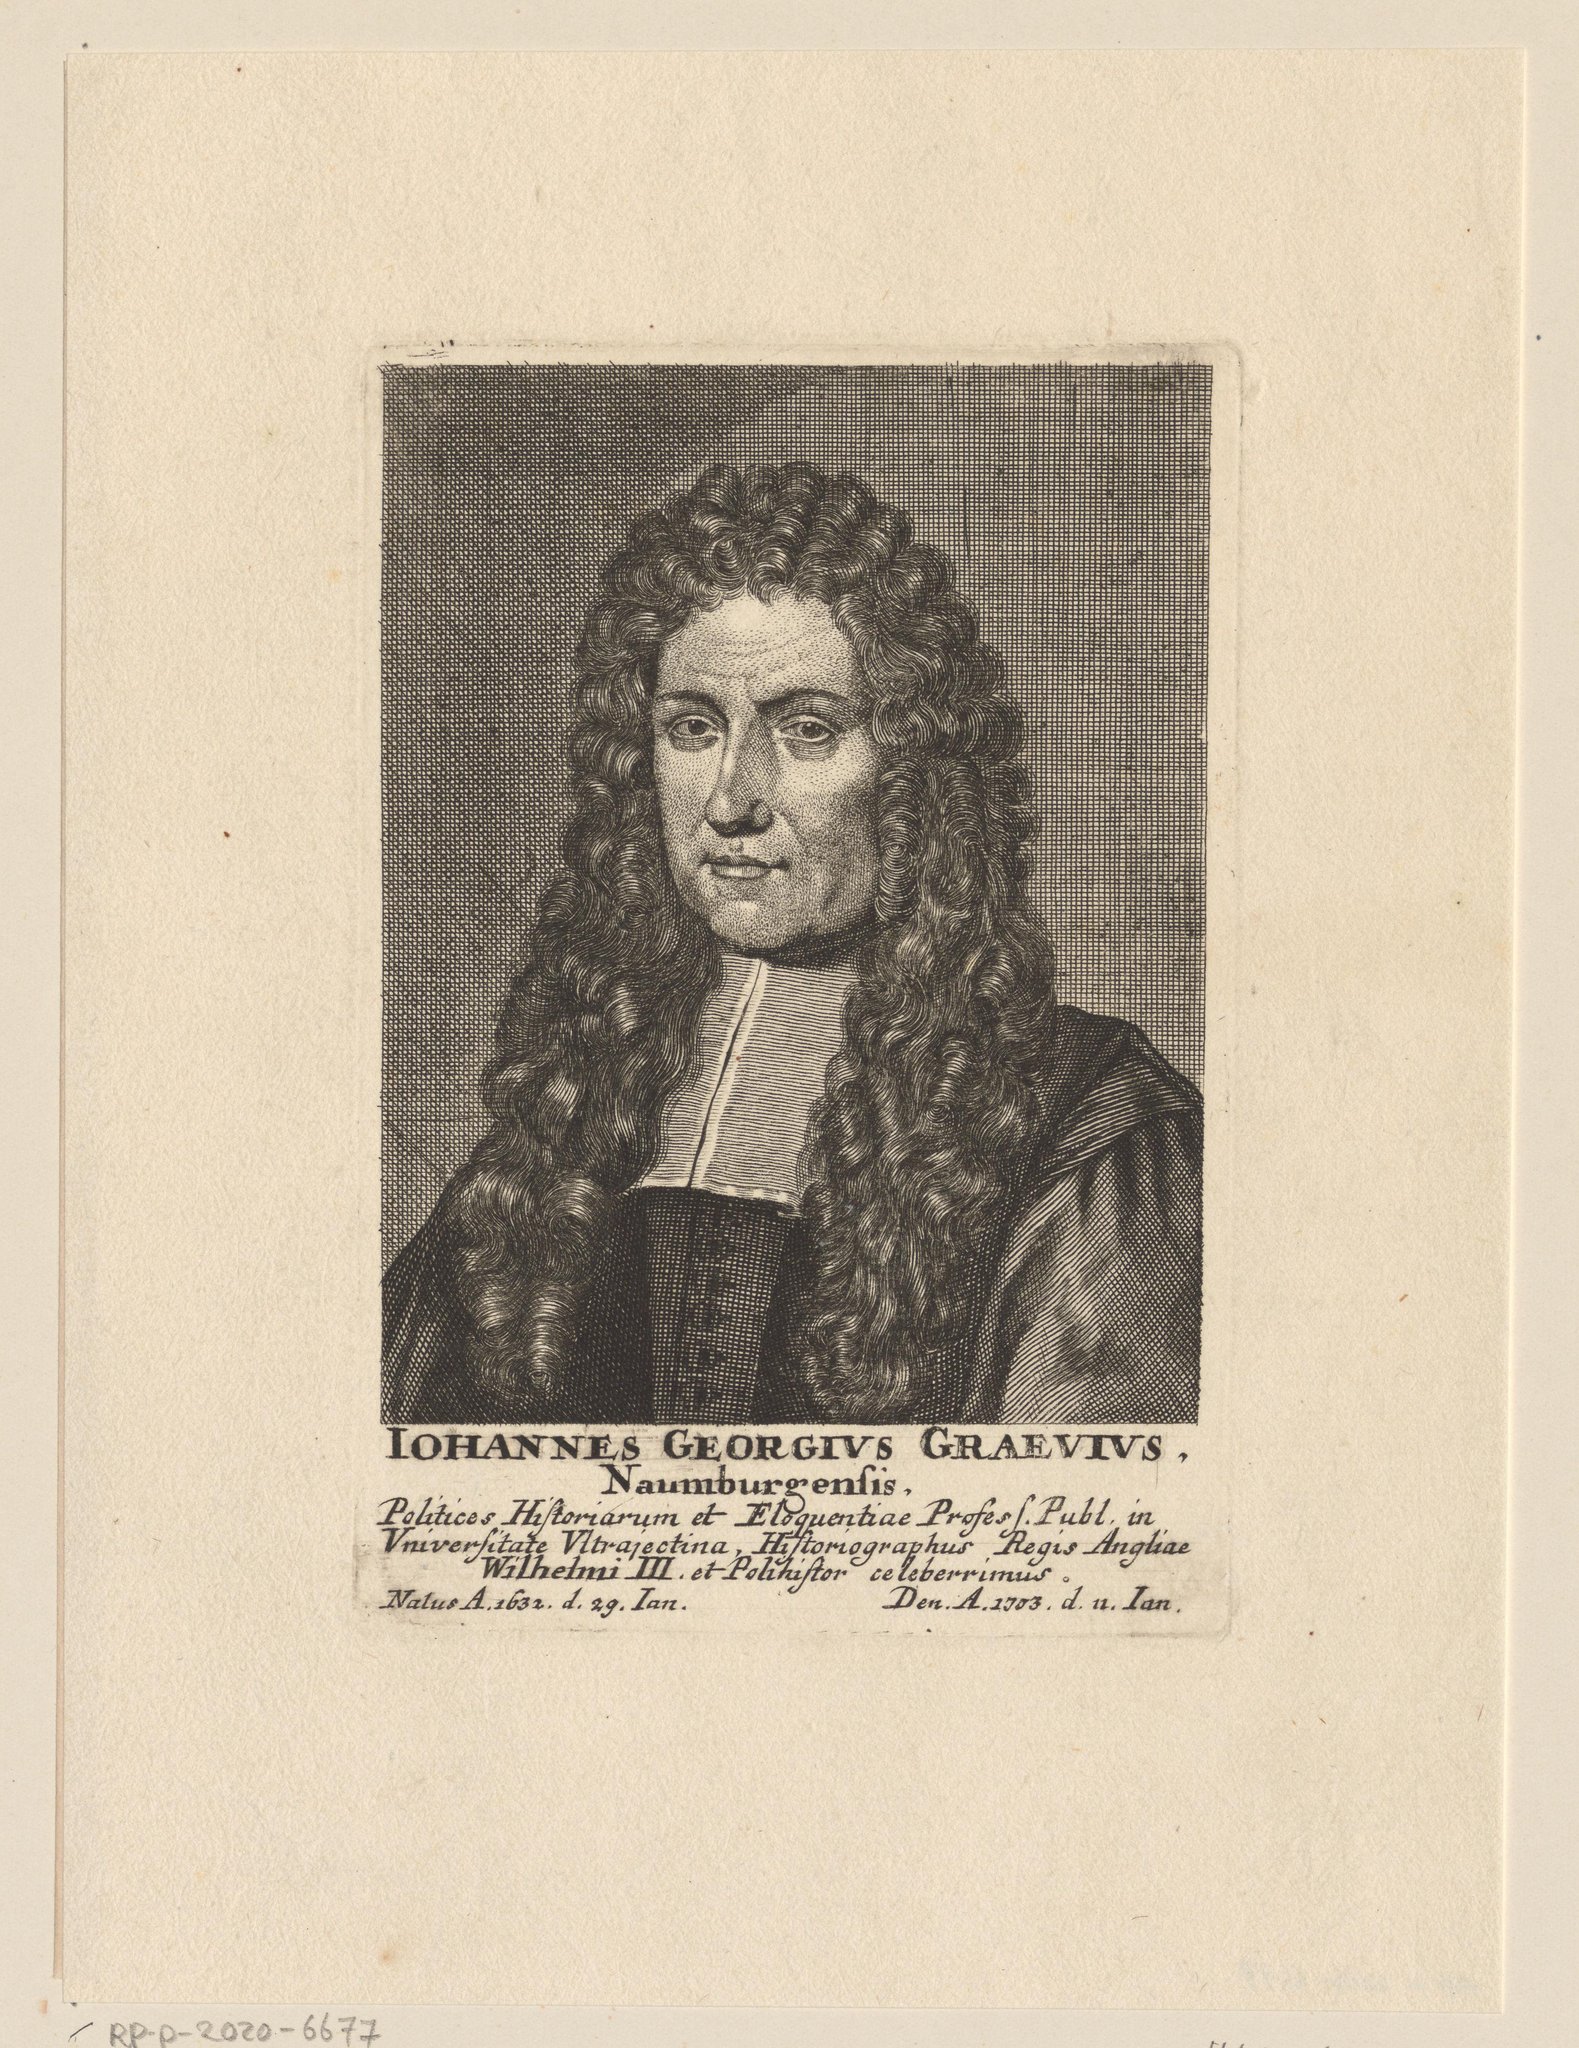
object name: print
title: Portret van Johann George Graevius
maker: Anonymous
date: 1703-1803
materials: paper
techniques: engraving, etching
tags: historical persons, scholar, philosopher (+ portrait of scholar, scientist)